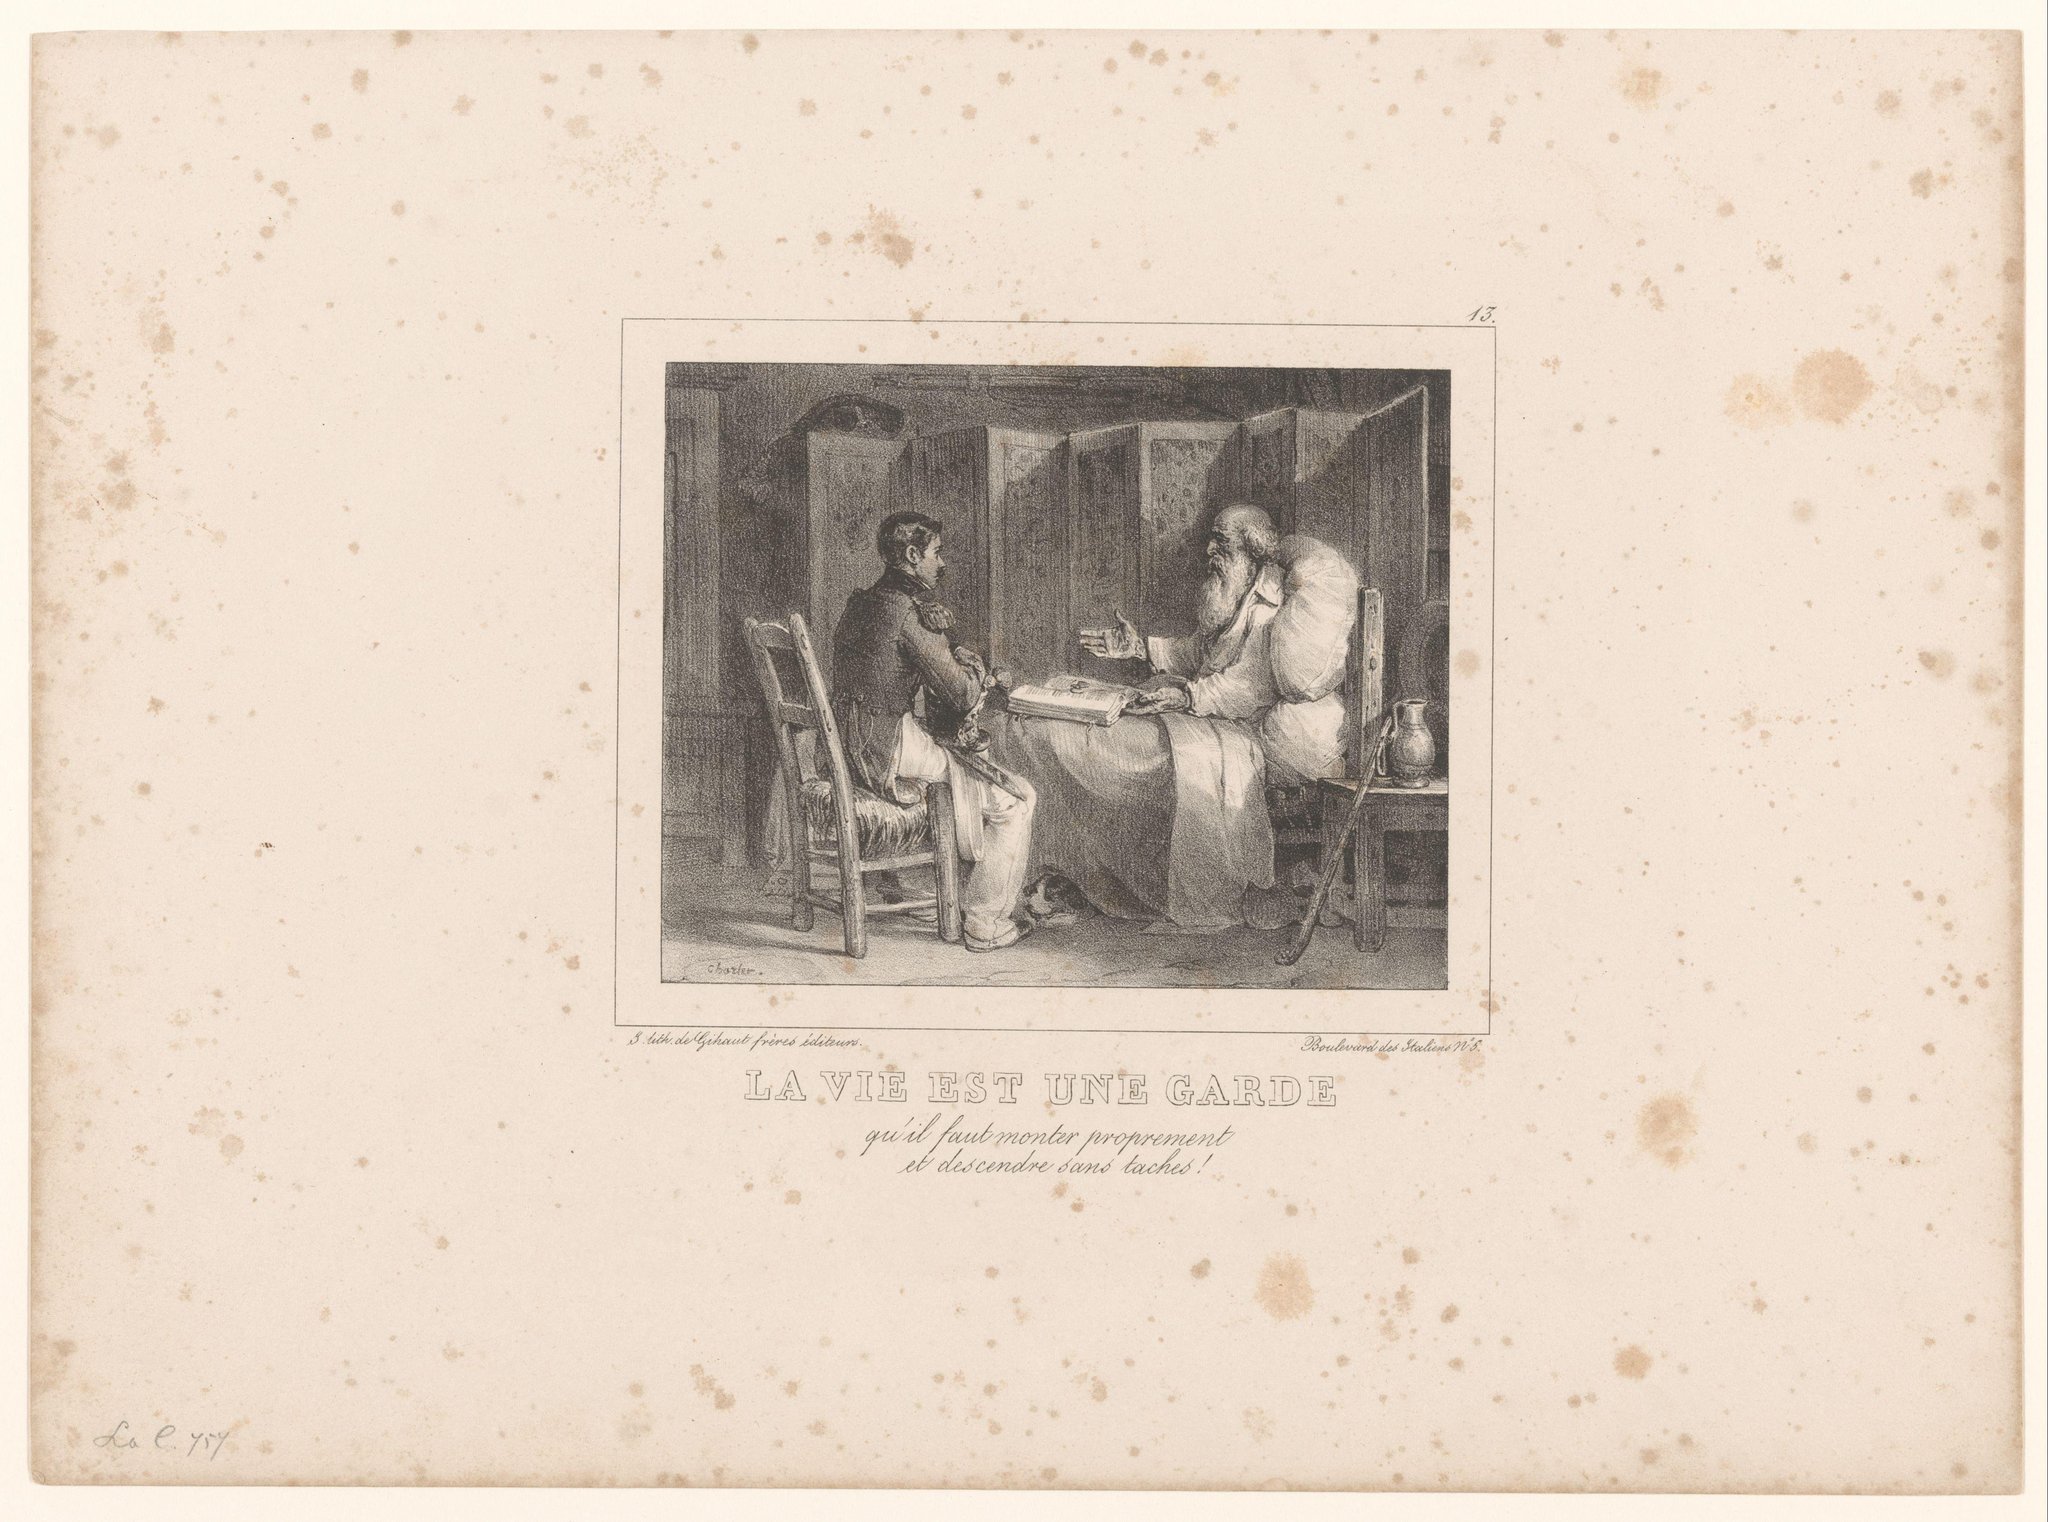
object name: print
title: Lithografisch album 1830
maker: nicolas toussaint charlet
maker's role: draughtsman, painter, print maker, printer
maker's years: 1792-1845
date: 1830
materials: paper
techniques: lithograph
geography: paris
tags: old man, wise man, the soldier off duty, education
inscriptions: collector's mark: Lugt 2228a